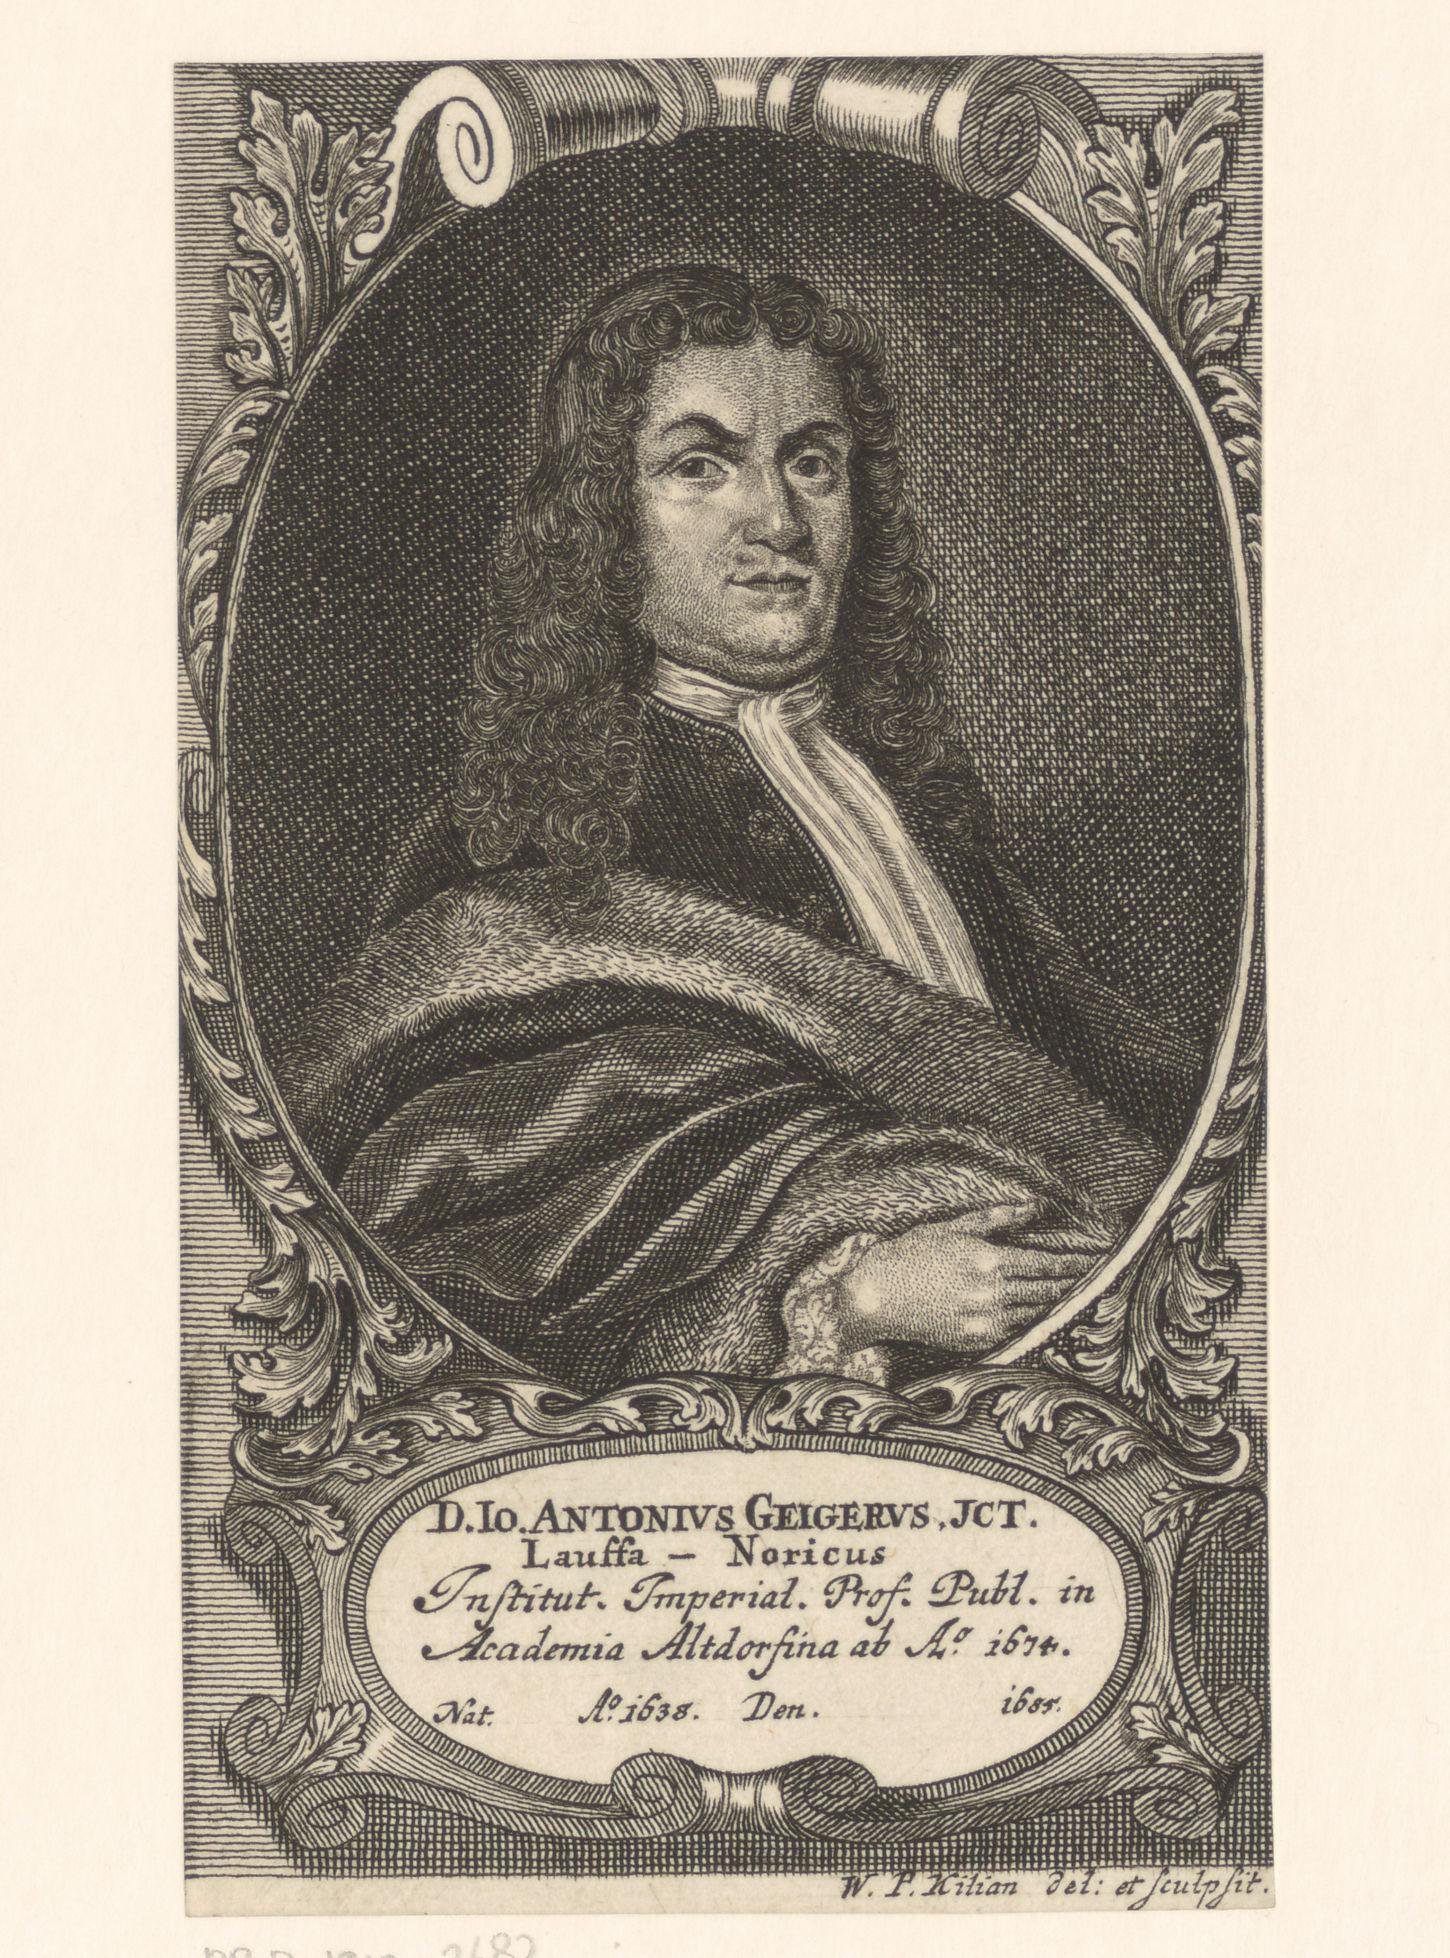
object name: print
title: Portret van Johann Anton Geiger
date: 1685-1732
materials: paper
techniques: engraving, etching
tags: further education (+ portrait of teacher, professor), historical persons, lawyer, attorney at law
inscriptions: collector's mark: Lugt 2228